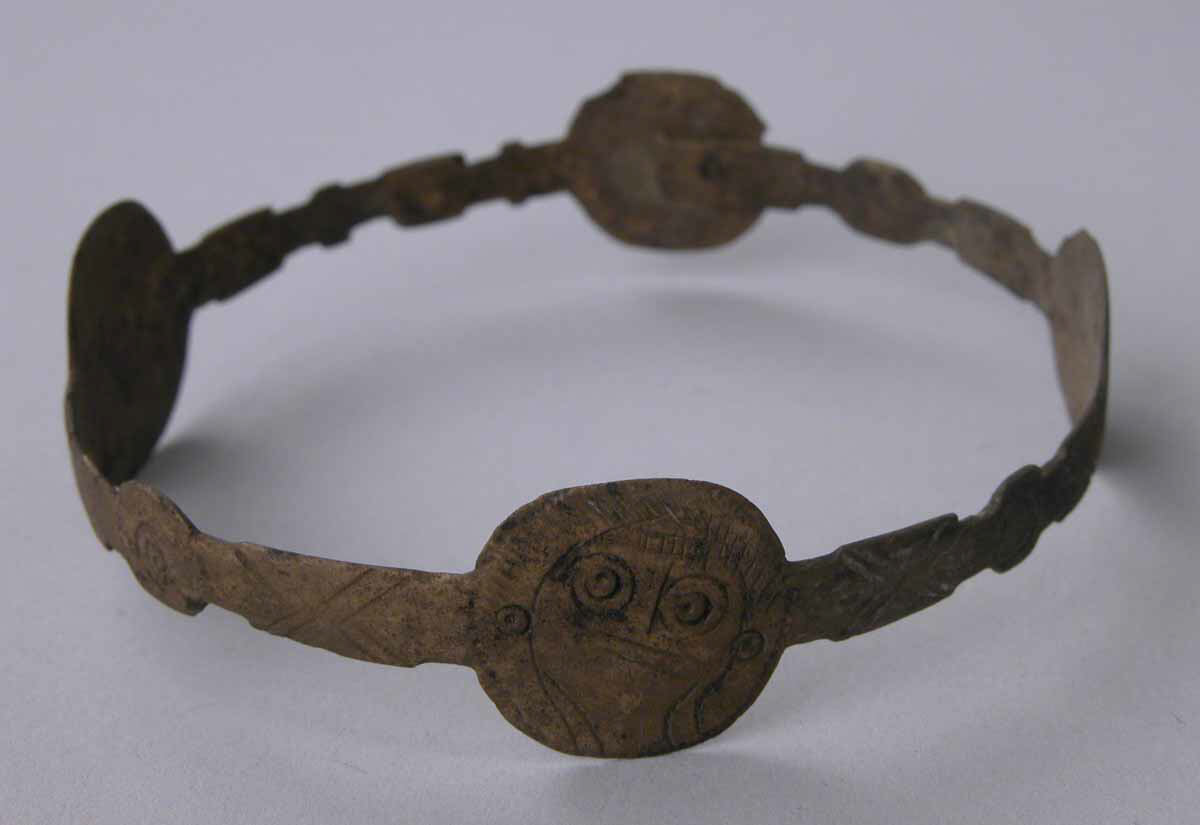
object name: bracelet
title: Copper-Alloy Bracelet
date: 501-800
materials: copper alloy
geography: egypt